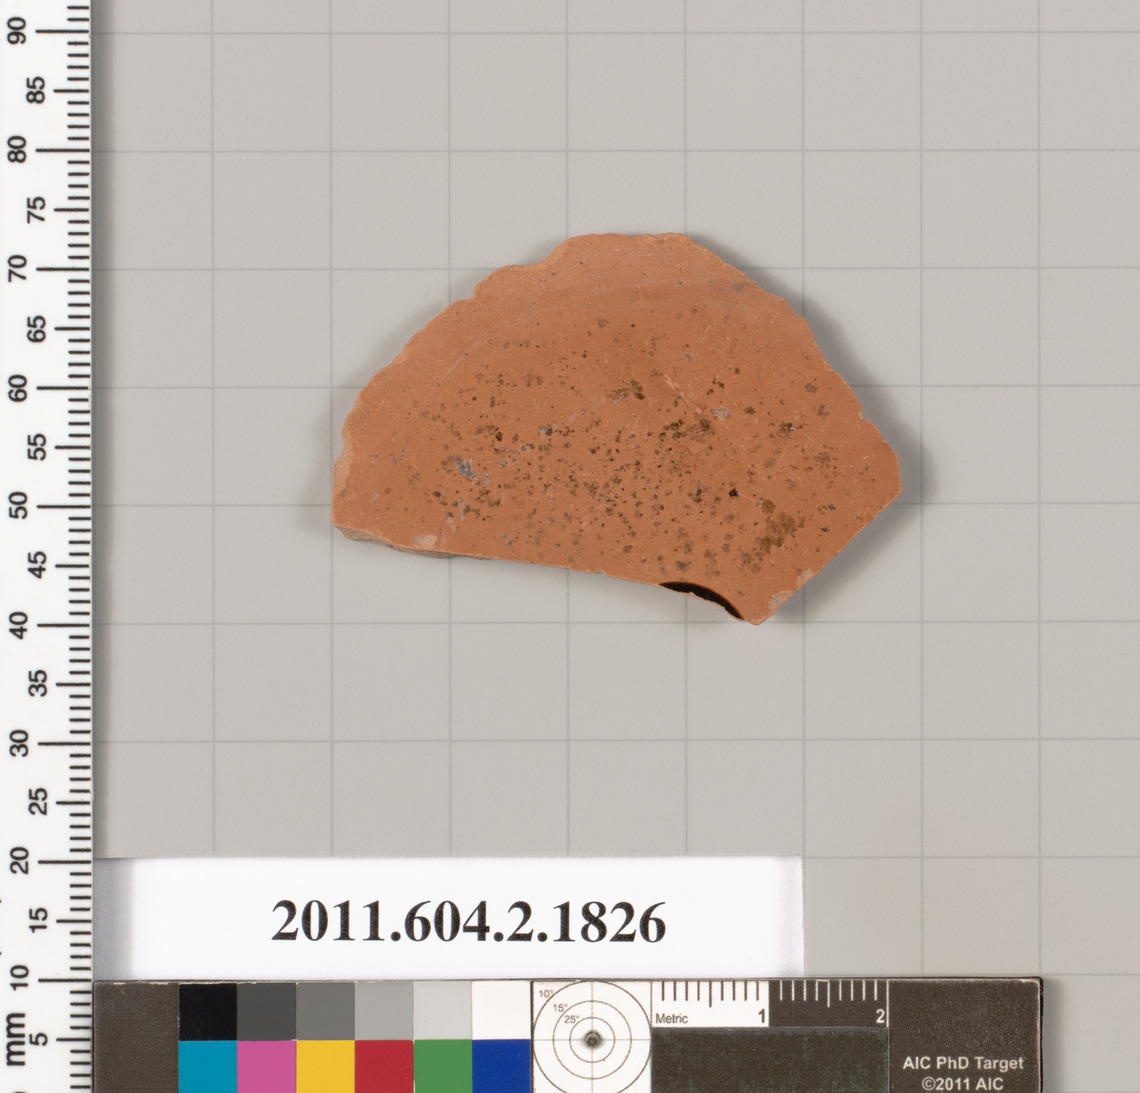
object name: skyphos fragment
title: Terracotta fragment of a skyphos (deep drinking cup)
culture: greek, attic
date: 450-401 BCE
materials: terracotta